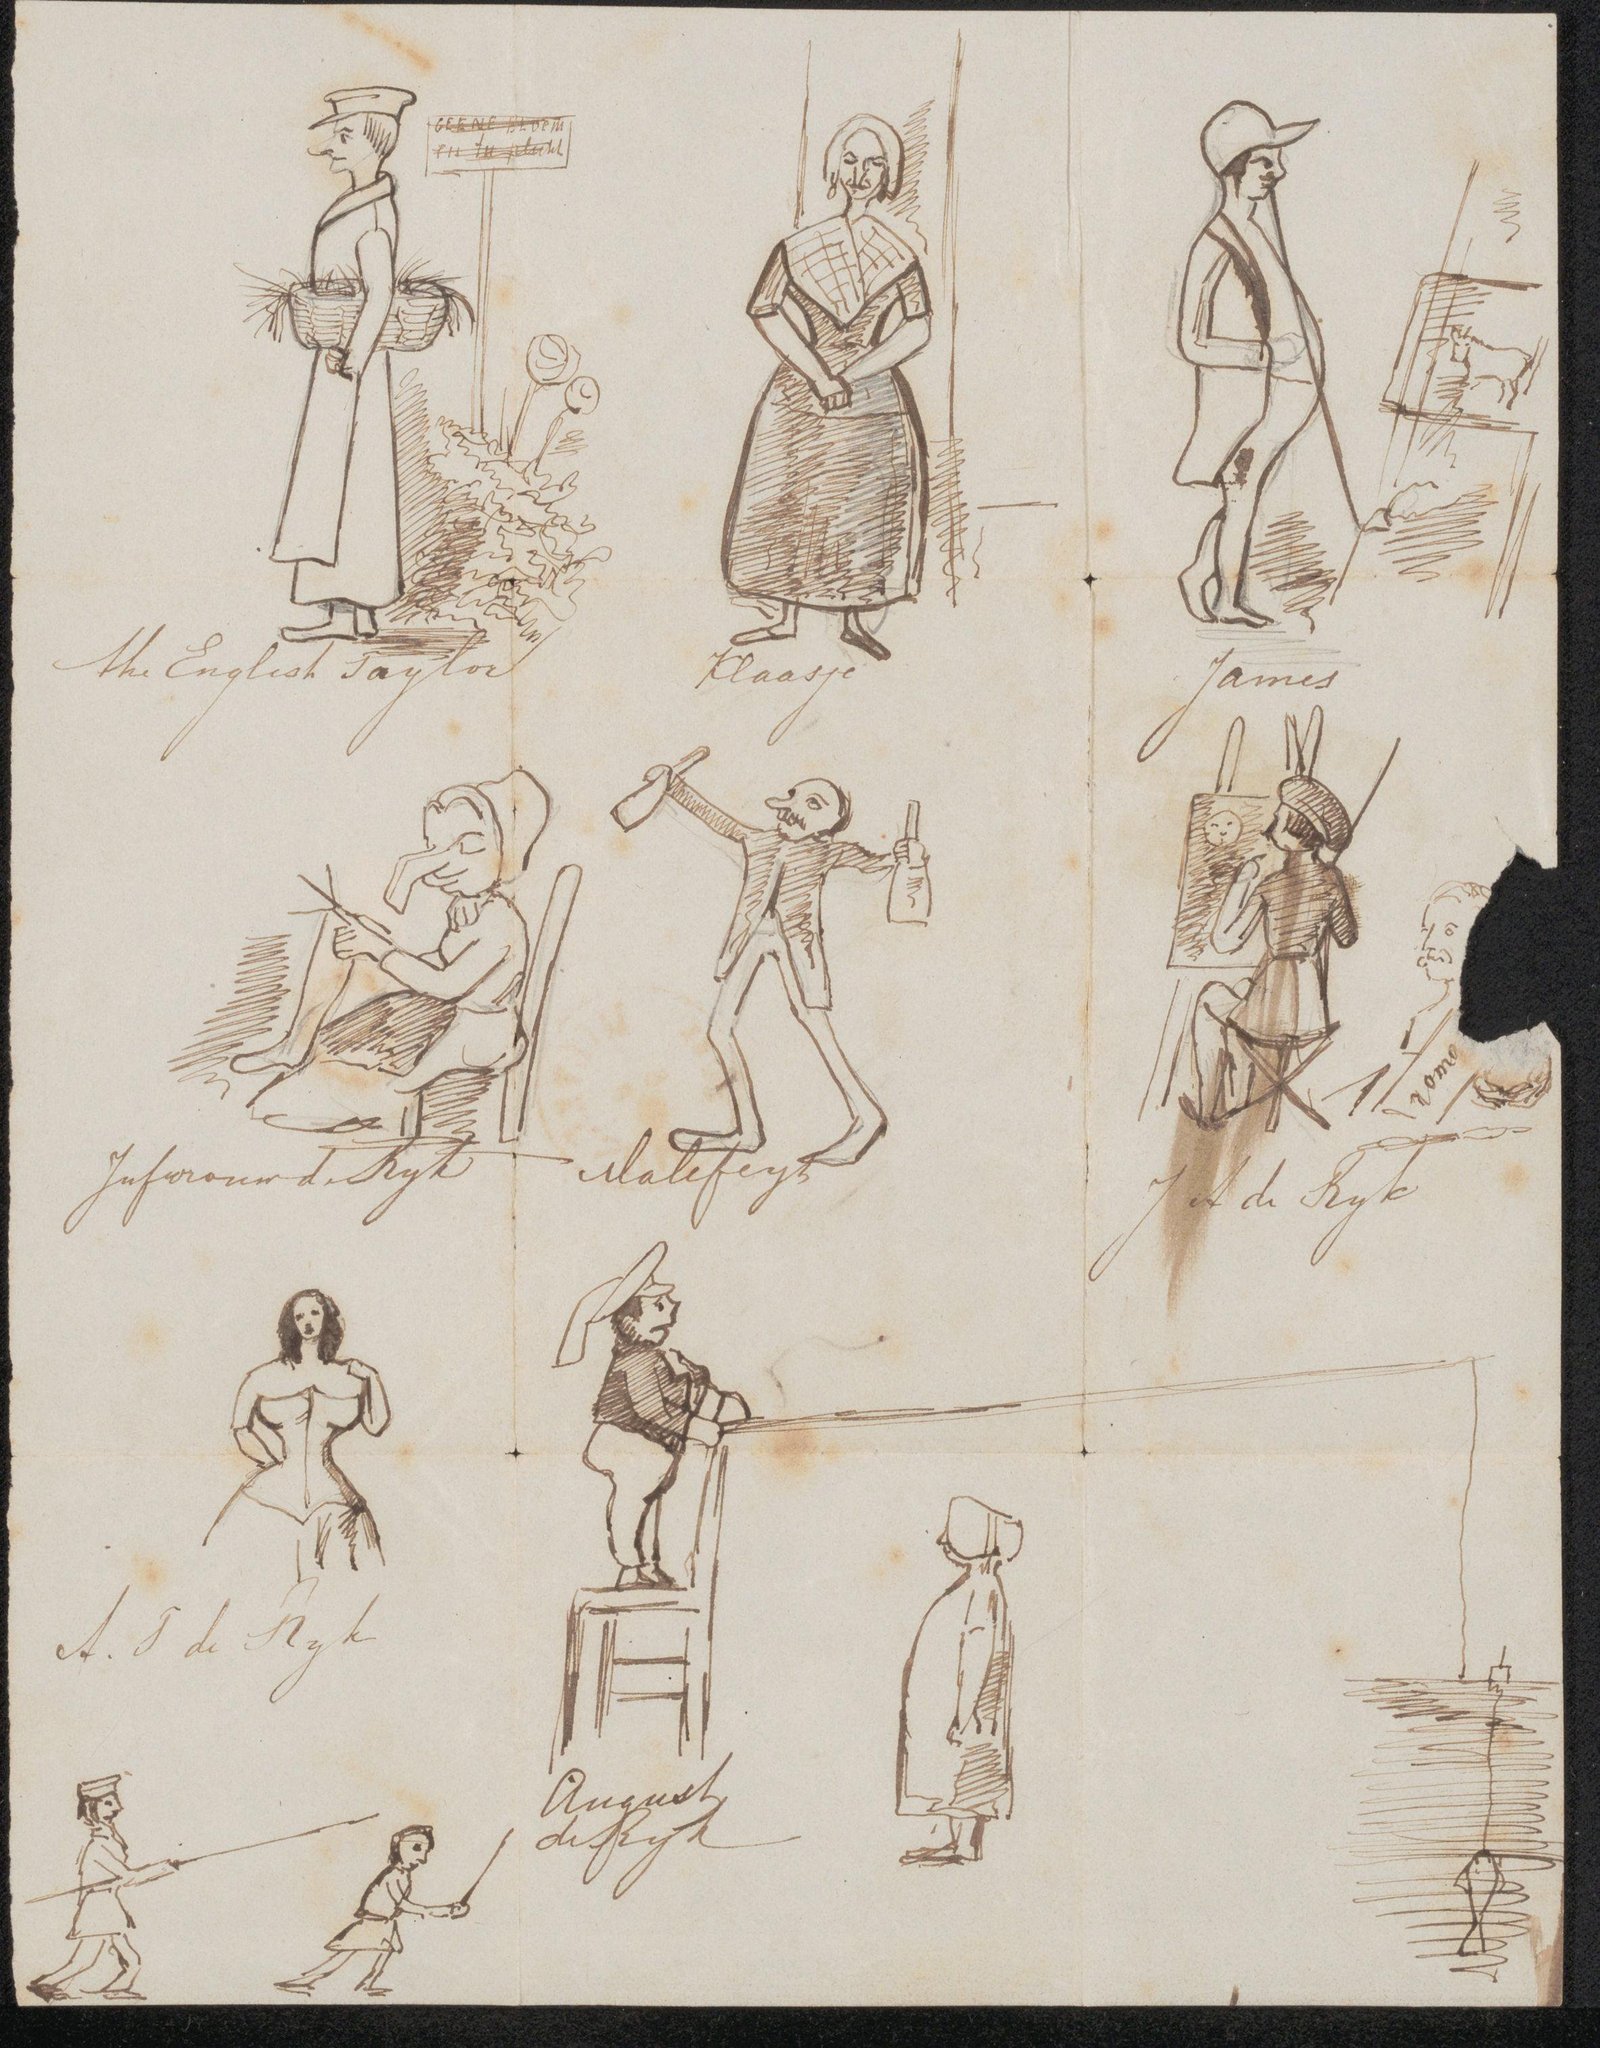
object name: drawing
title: Tekening aan mevrouw Allebé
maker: Anonymous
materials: ink, paper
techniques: pen, writing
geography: hilversum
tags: painter, draughtsman, haarlem, print maker, james de rijk, amsterdam, gerard arnold nicolaas allebé, portrait, self-portrait of painter, painter at work, in his studio, fishing (sports), knitting, historical persons (portraits and scenes from the life)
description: Tekening werd bewaard in een bruinleren omslag met goudopdruk `1836 Hulde aan Dr. G.A.N. Allebé 1886', met daarin brieven, tekeningen en gedichten afkomstig uit de familie van de schilder August Allebé.